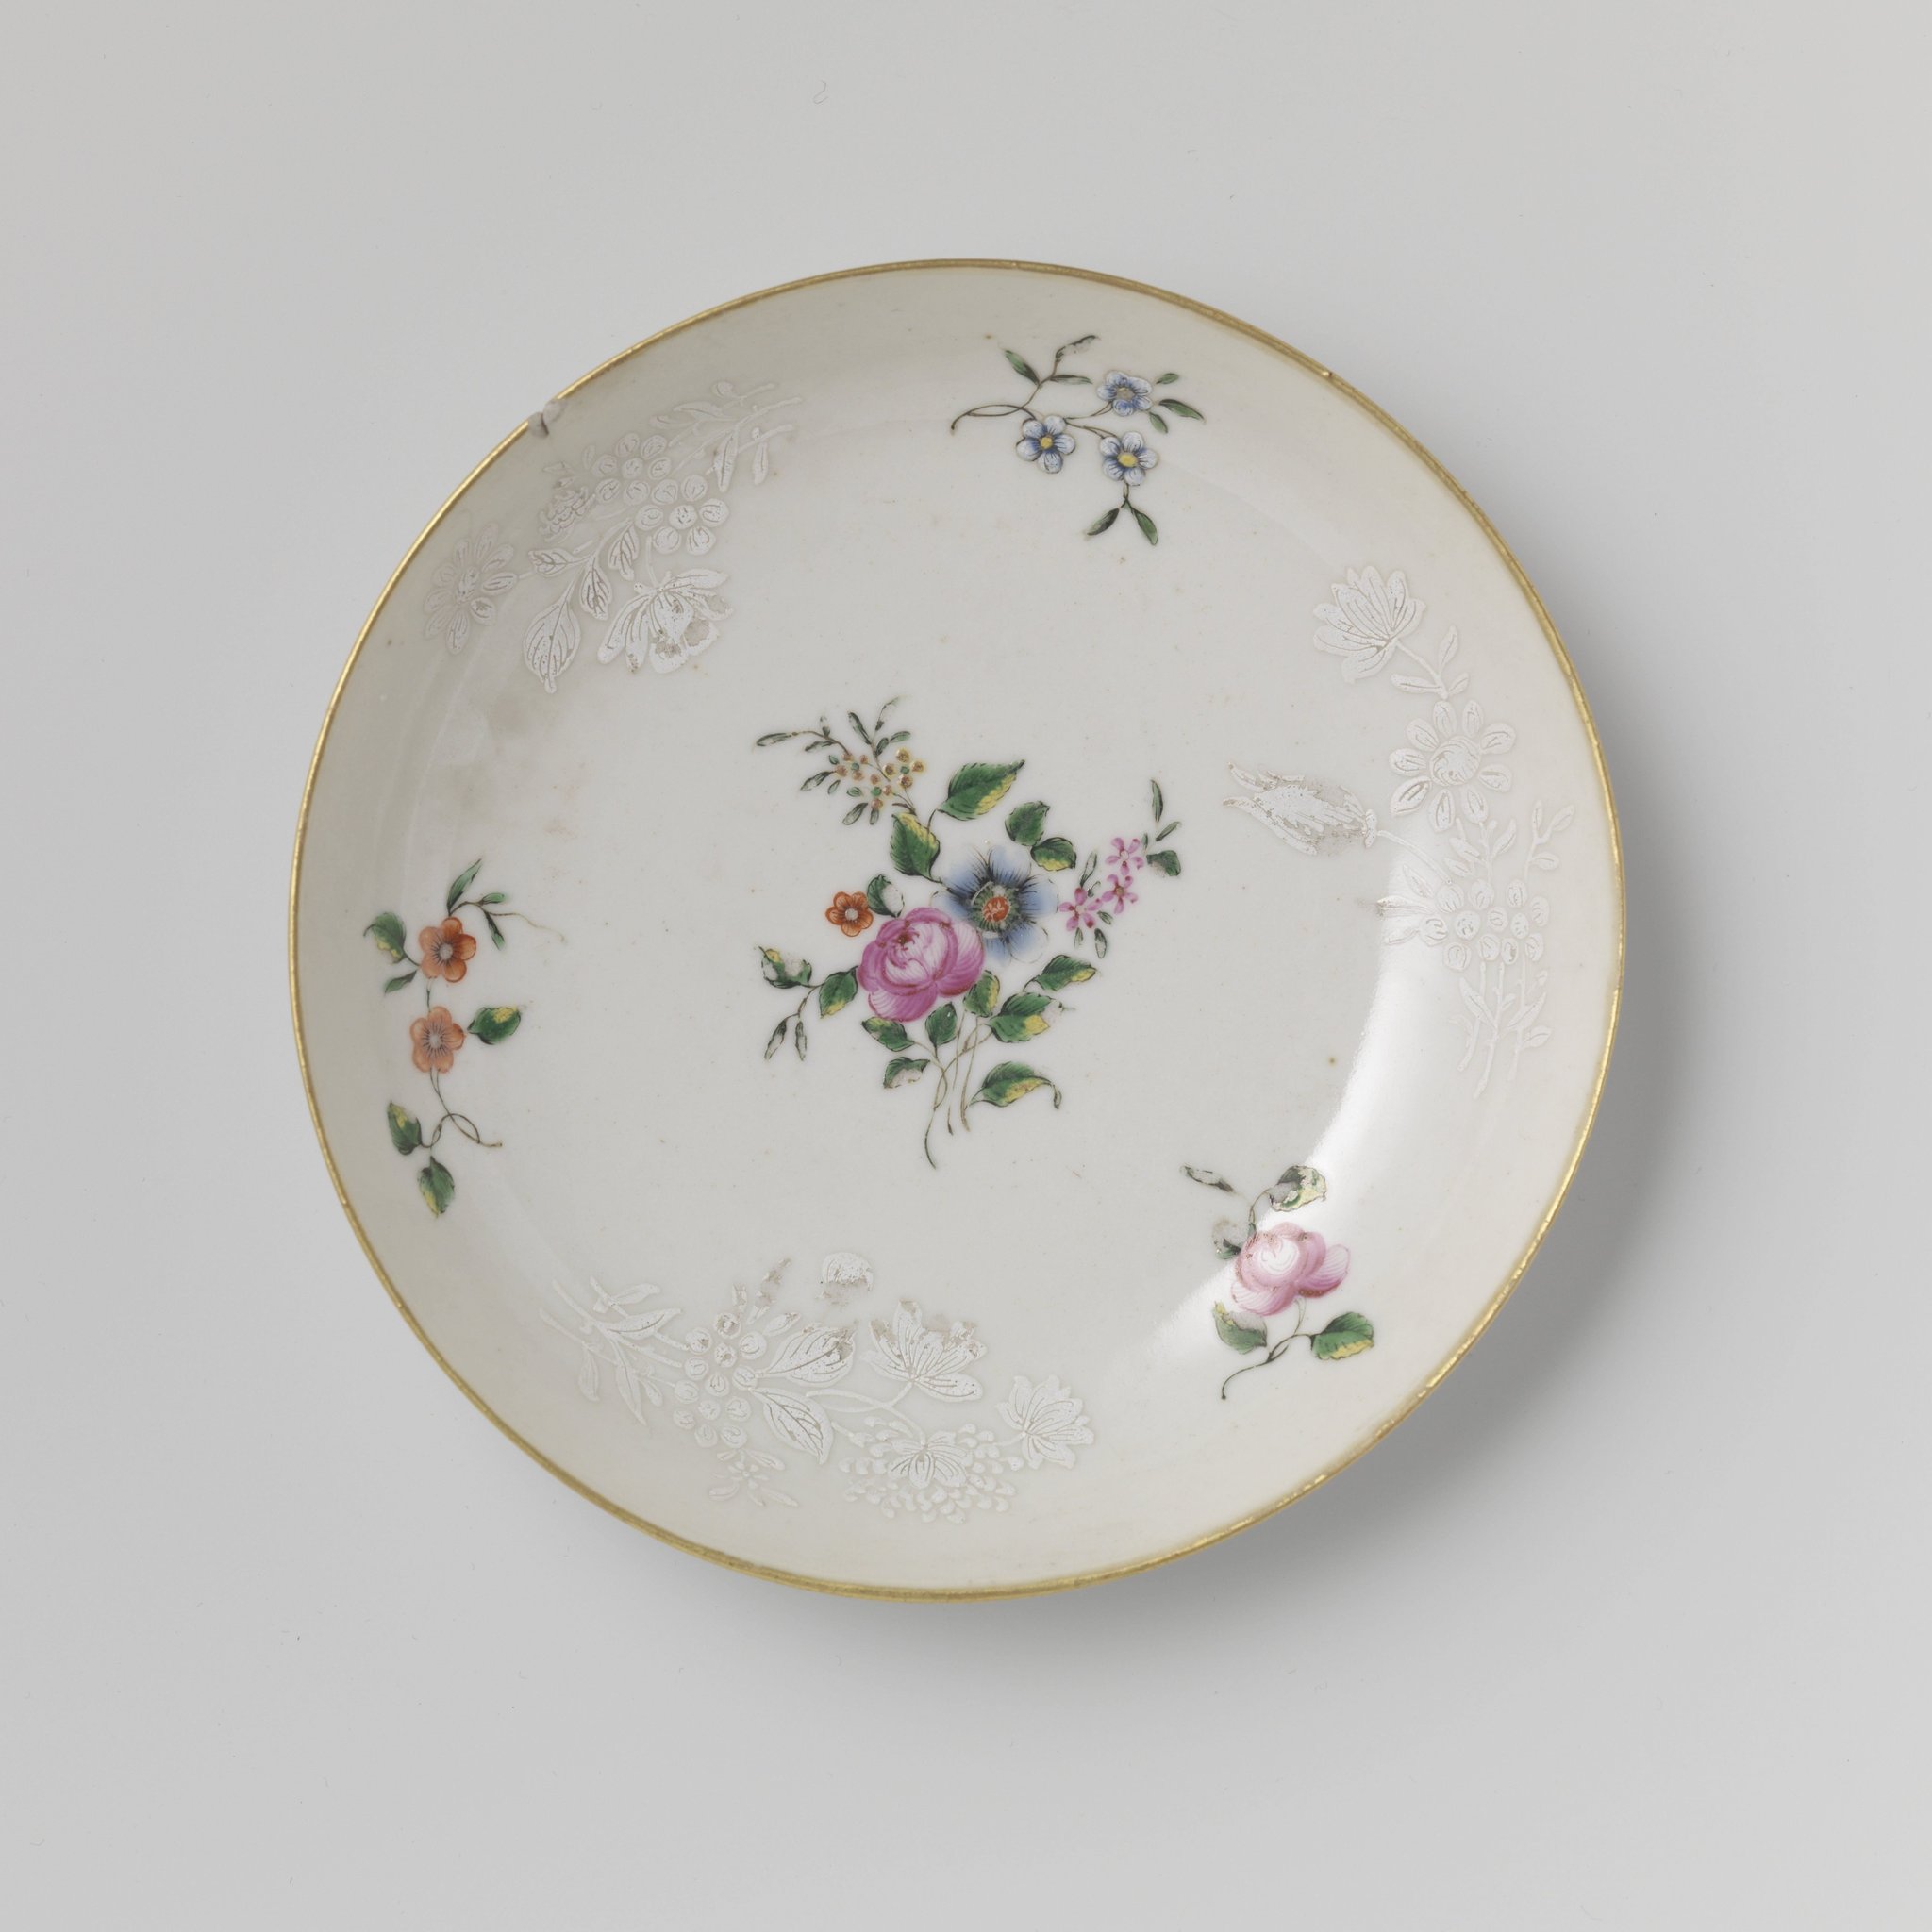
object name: platter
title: Saucer with flower sprays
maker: Anonymous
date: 1775-1799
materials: glaze, gold, paint, porcelain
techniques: firing, gilding, turning, vitrification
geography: china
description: Schotel van porselein, beschilderd op het glazuur in blauw, rood, roze, groen, geel, zwart en goud. De voorzijde met drie bloemtakken op de wand en een bloemgroep in het centrum in roze emails; tussen de bloemtakken op de wand driemaal een bloemgroep in bianco sopra bianco. Een barst in de wand. Famille rose.